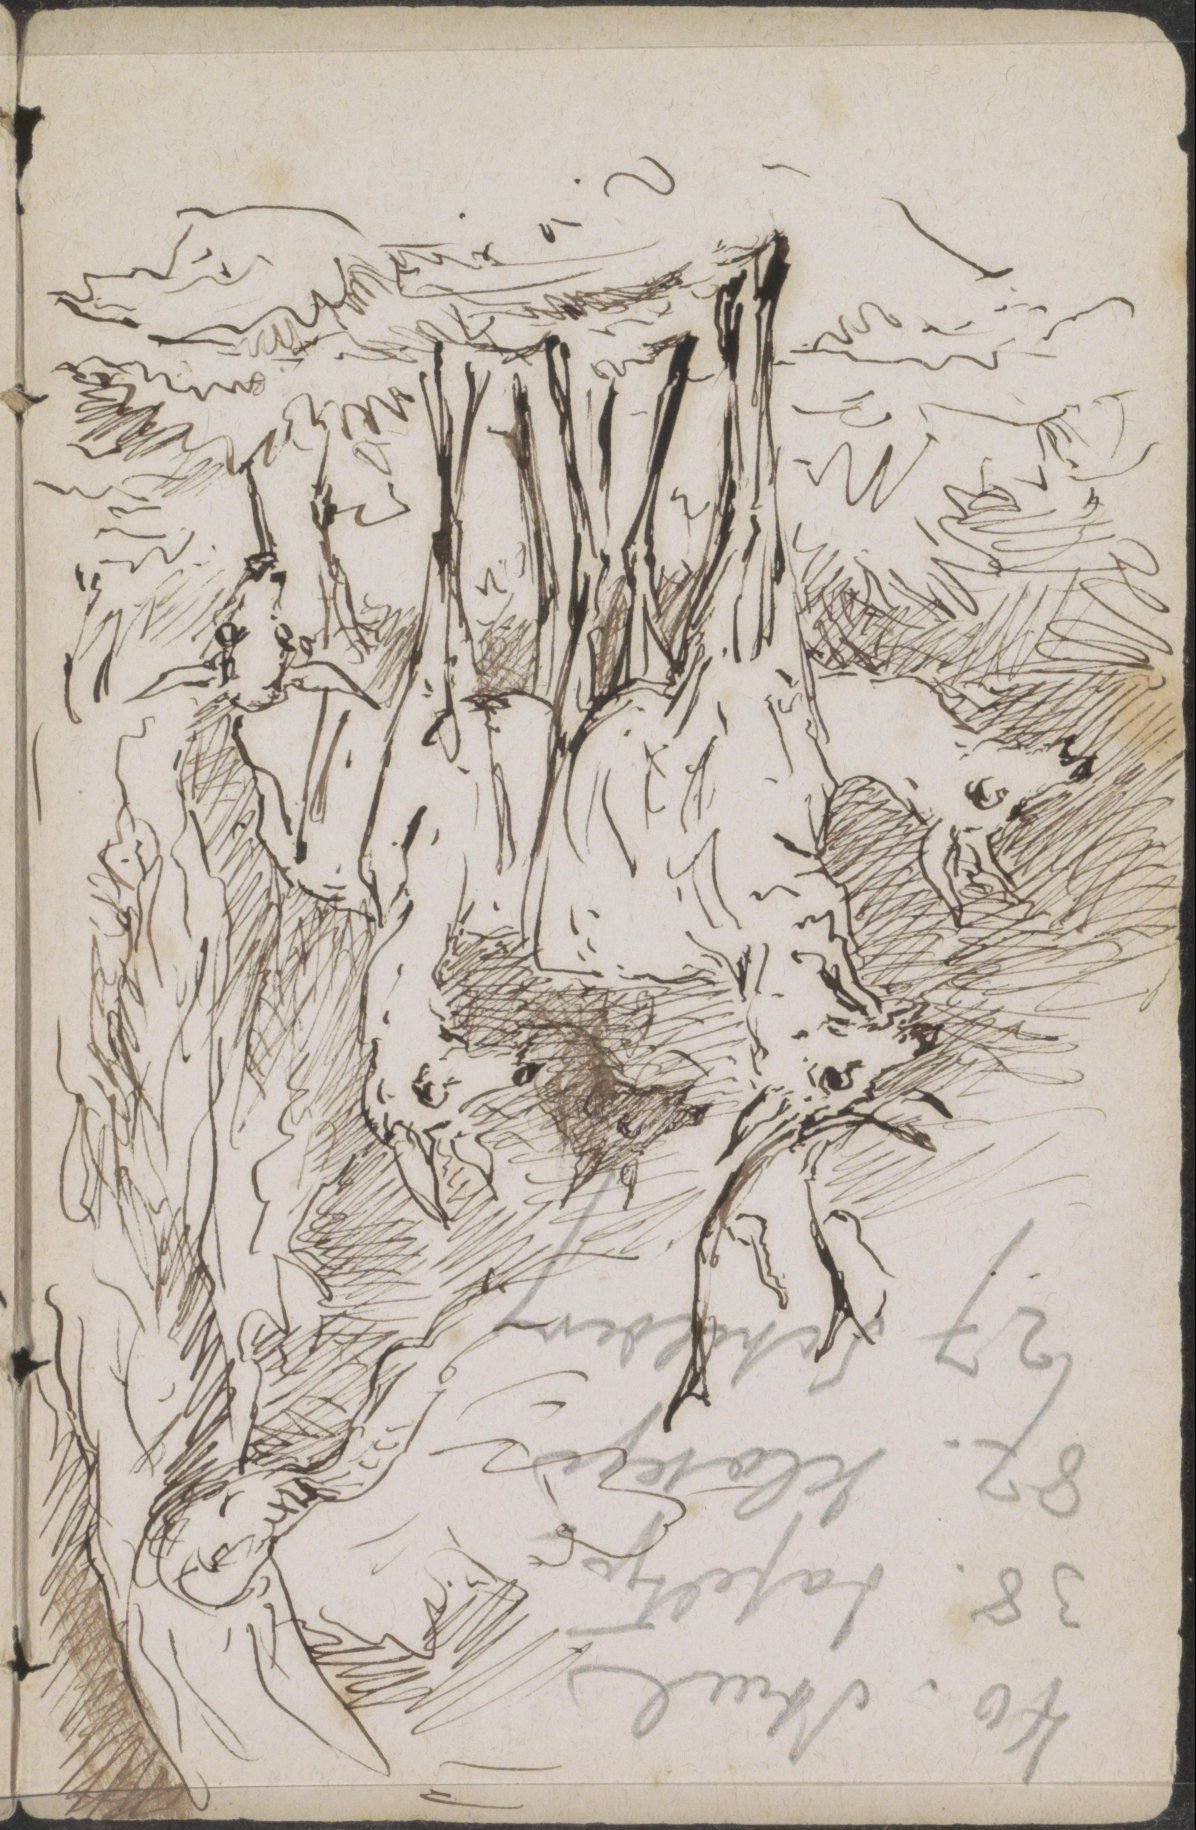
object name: sketchbook leaf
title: Herten bij een boom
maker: johannes tavenraat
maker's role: draughtsman, painter, print maker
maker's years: 1809-1881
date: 1862-1864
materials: ink, paper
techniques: pen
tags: trees, hoofed animals: deer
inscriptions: annotation: ‘40. stoel/ 38. tafeltje/ 87. klo[...]/ 27. schilderij’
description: Blad 65 recto uit een schetsboek met 65 bladen.